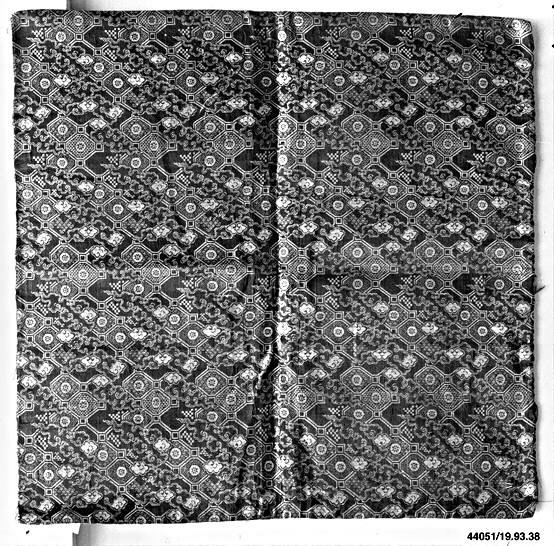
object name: altar cloth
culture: japanese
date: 1673-1681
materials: metal thread, silk